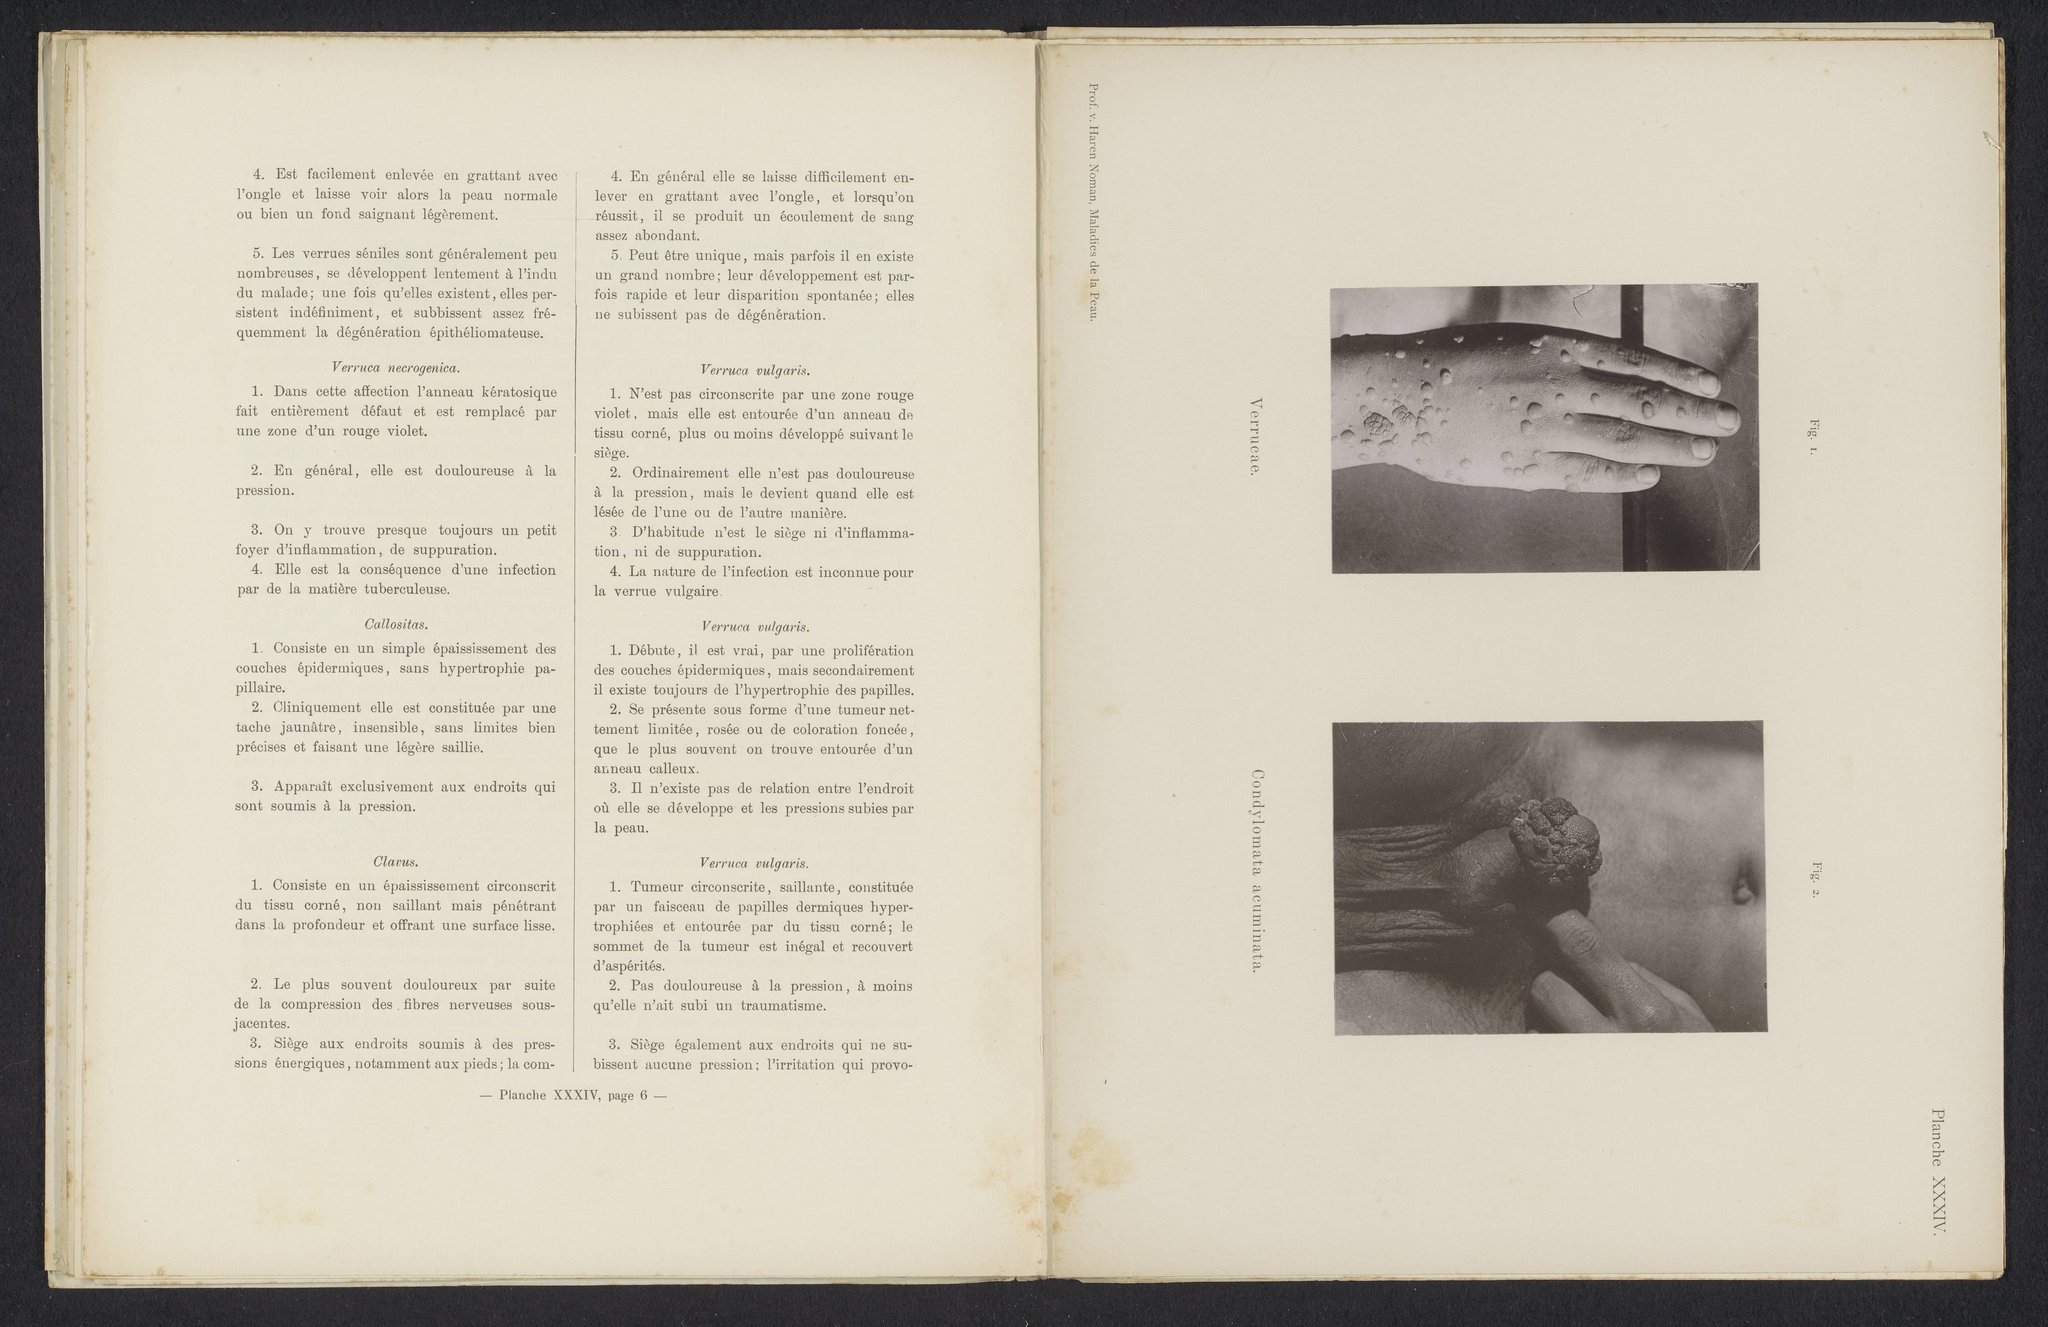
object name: page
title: Verrucae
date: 1890-1900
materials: paper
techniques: photograph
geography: amsterdam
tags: skin and venereal diseases, hand, penis, phallus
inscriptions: number: ‘Planche XXXIV. / Fig. 1. / Fig. 2.’